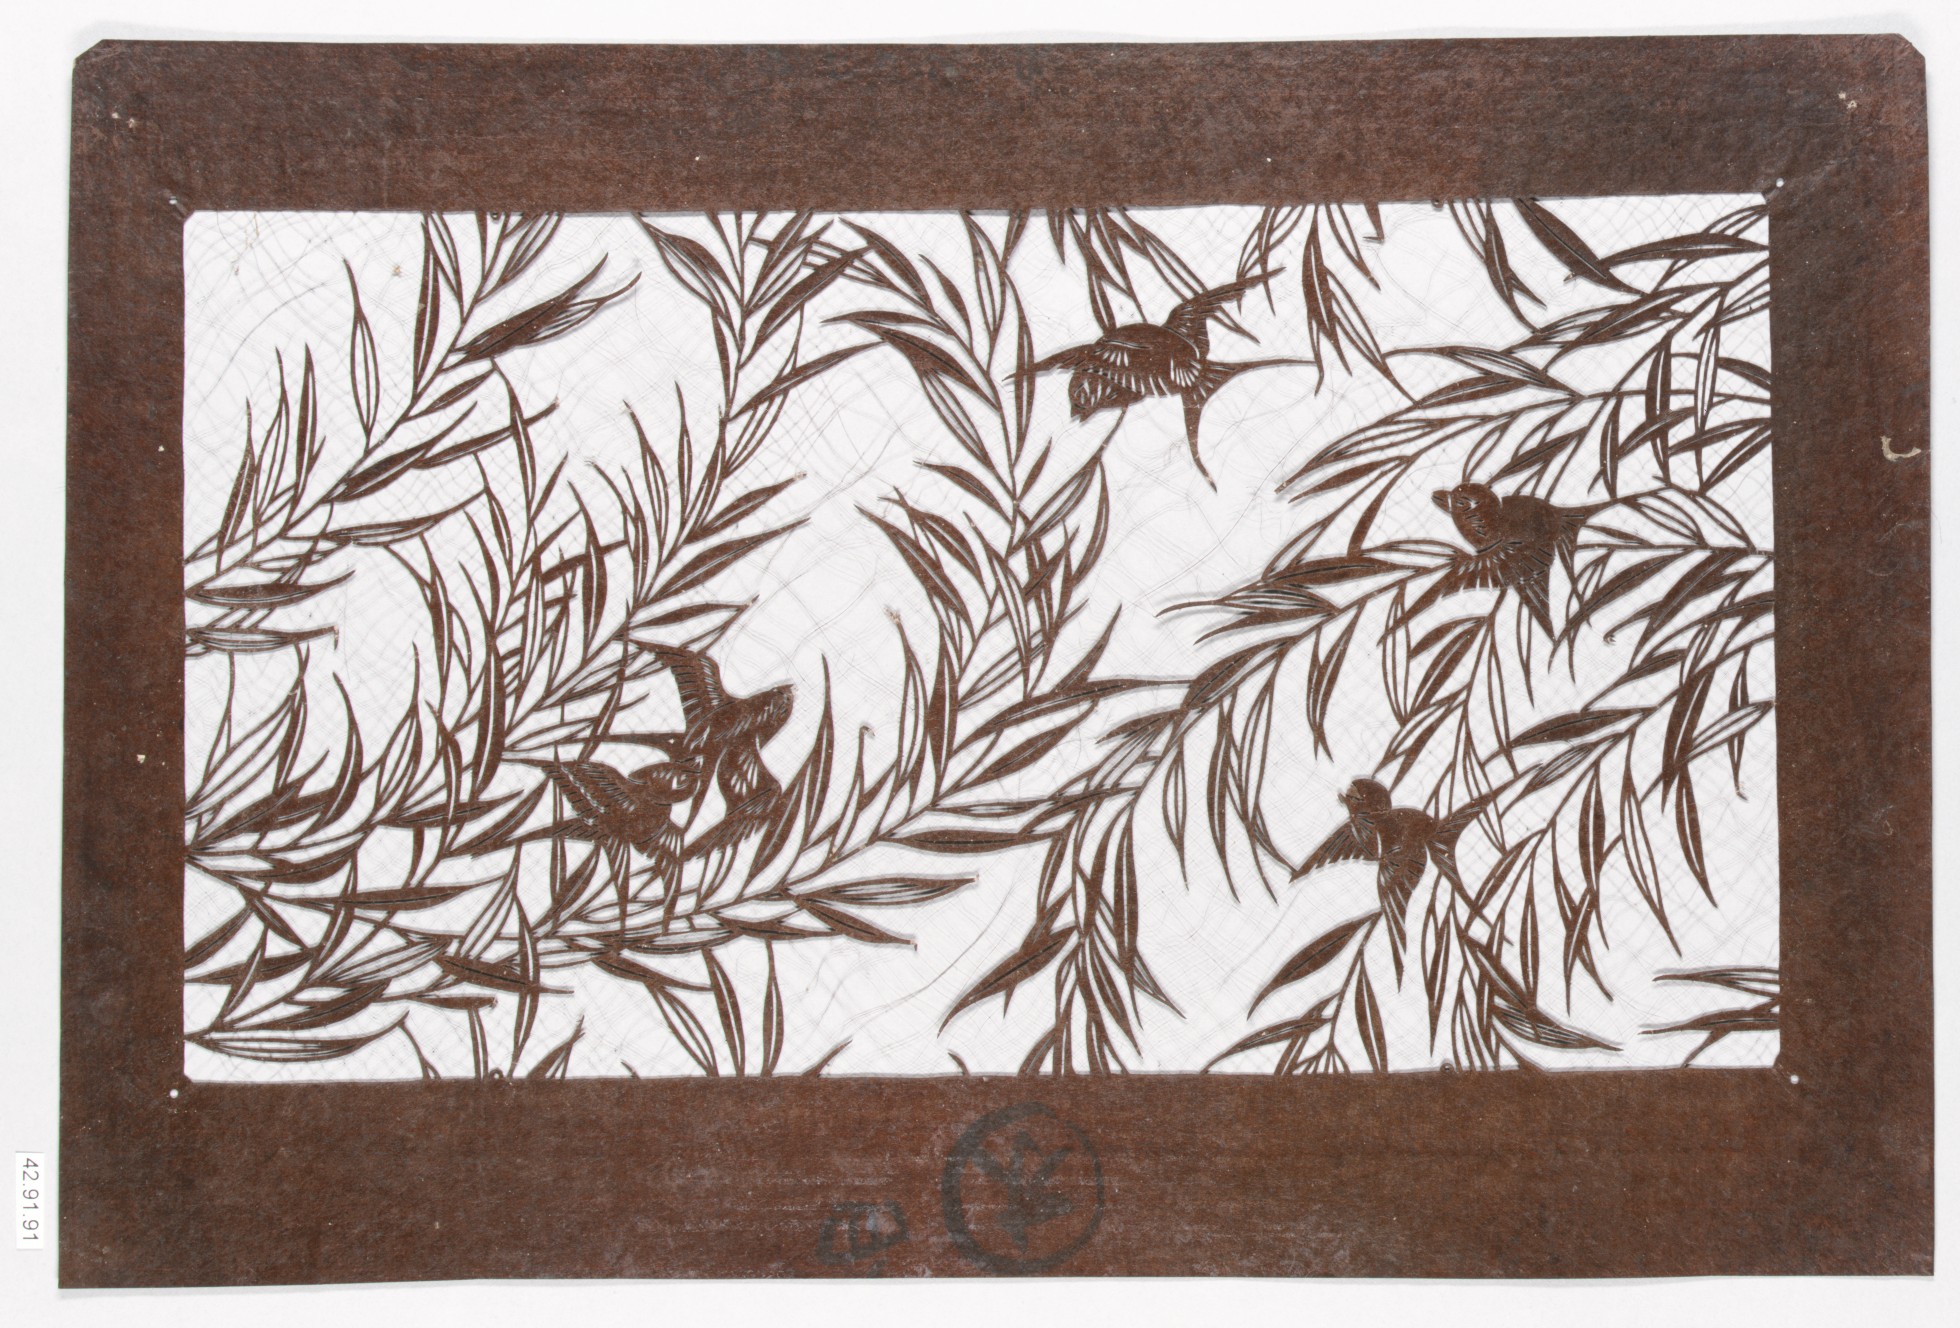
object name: stencil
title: Swallows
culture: japanese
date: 1801-1900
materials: paper, silk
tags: birds